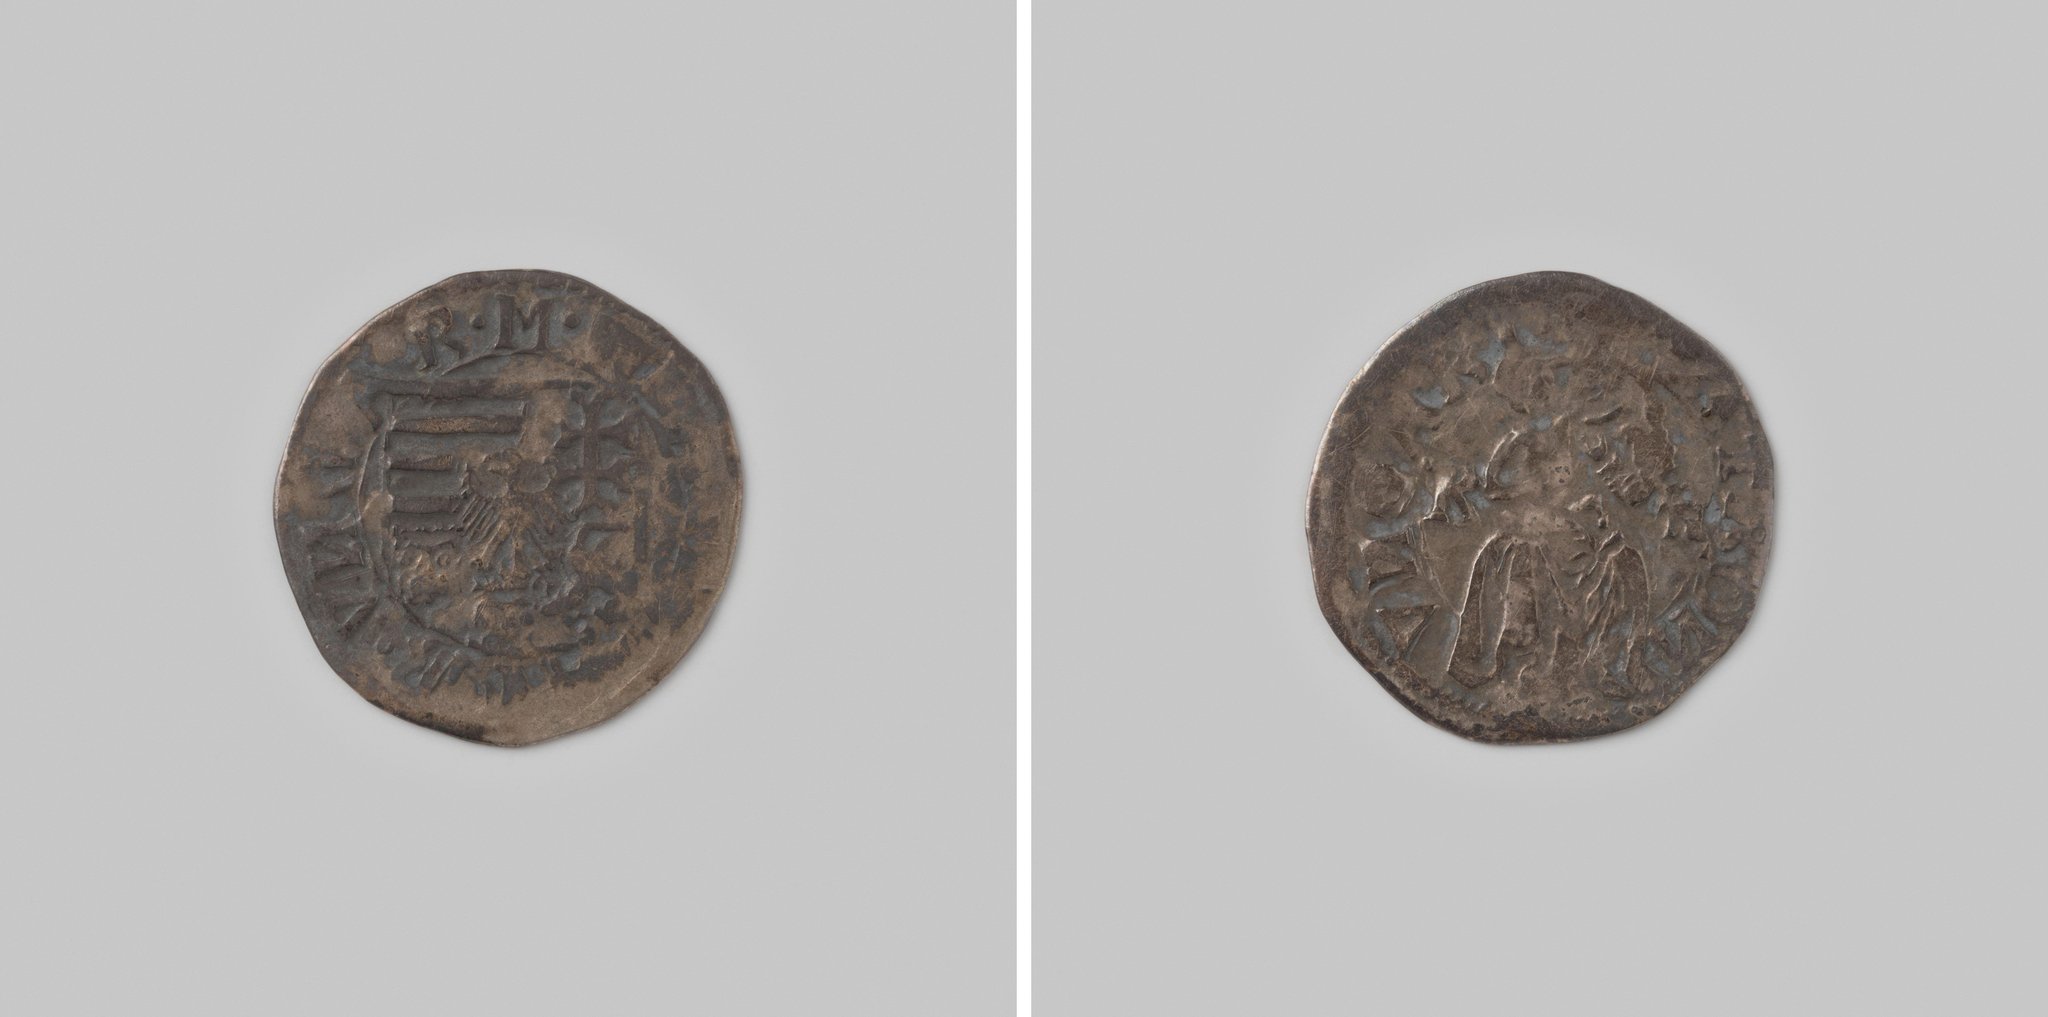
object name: coin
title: Hongarije, penning, koning Matthias Corvinus,1458-1490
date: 1458-1490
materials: silver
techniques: striking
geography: kremnica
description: Zilveren munt. Voorzijde: samengesteld wapenschild. Keerzijde: zittende figuur, beschermheilige.